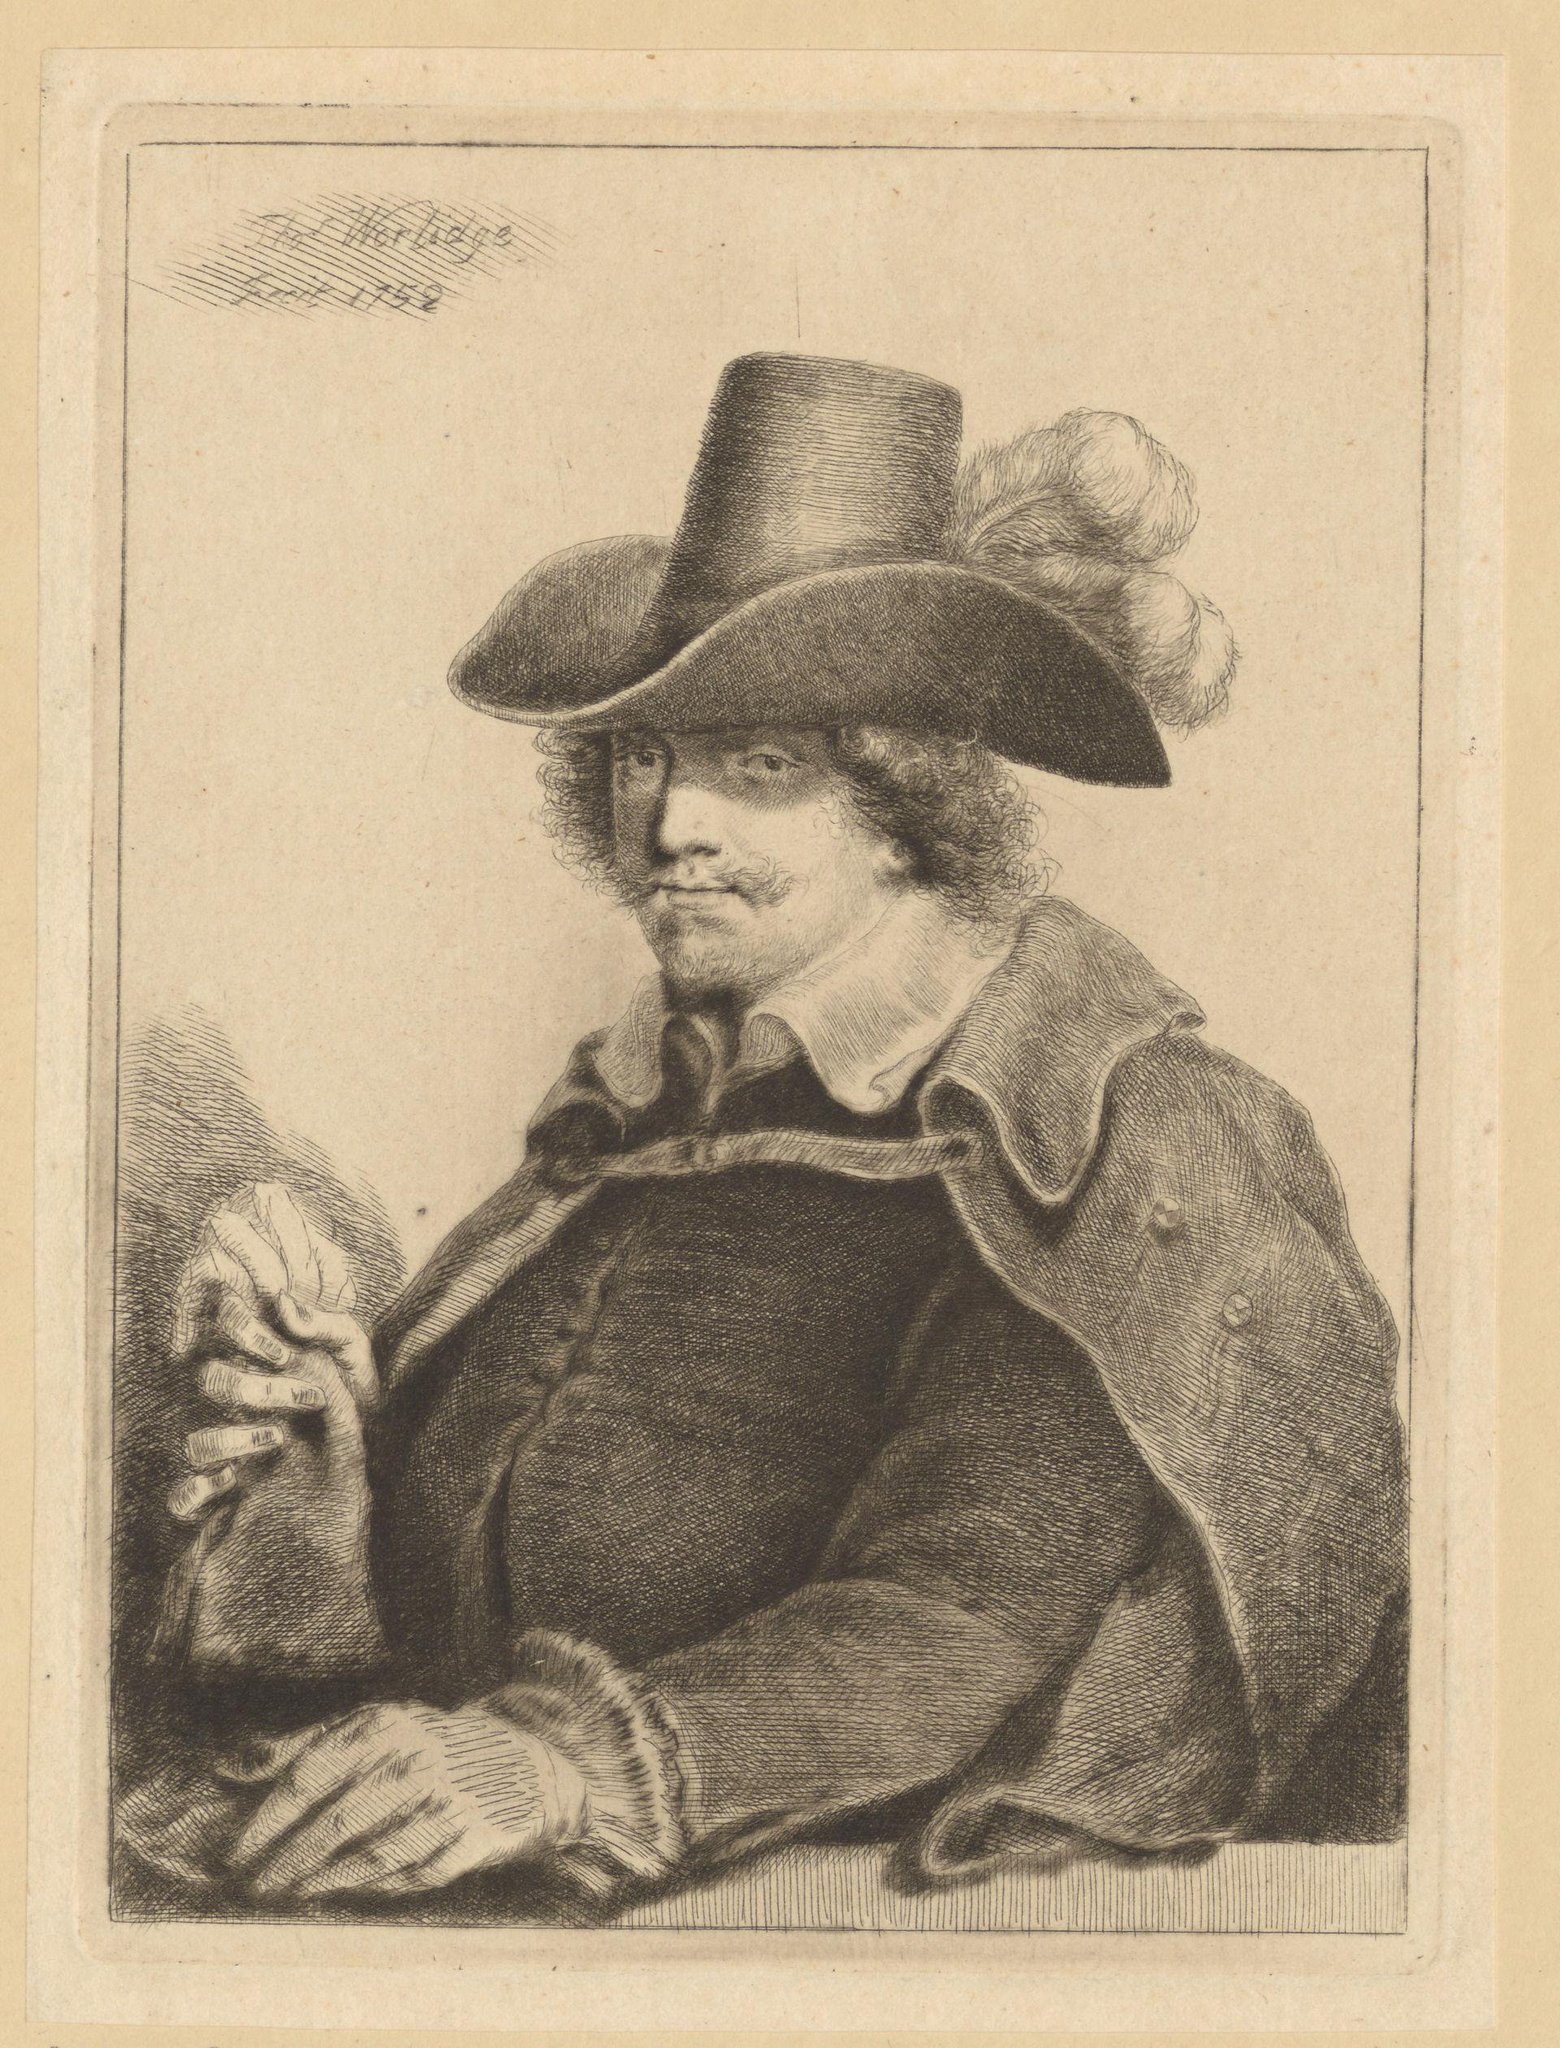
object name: print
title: Portret van Eduard van York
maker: thomas worlidge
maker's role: print maker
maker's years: 1700-1766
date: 1752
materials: paper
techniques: drypoint, etching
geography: london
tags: historical persons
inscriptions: date